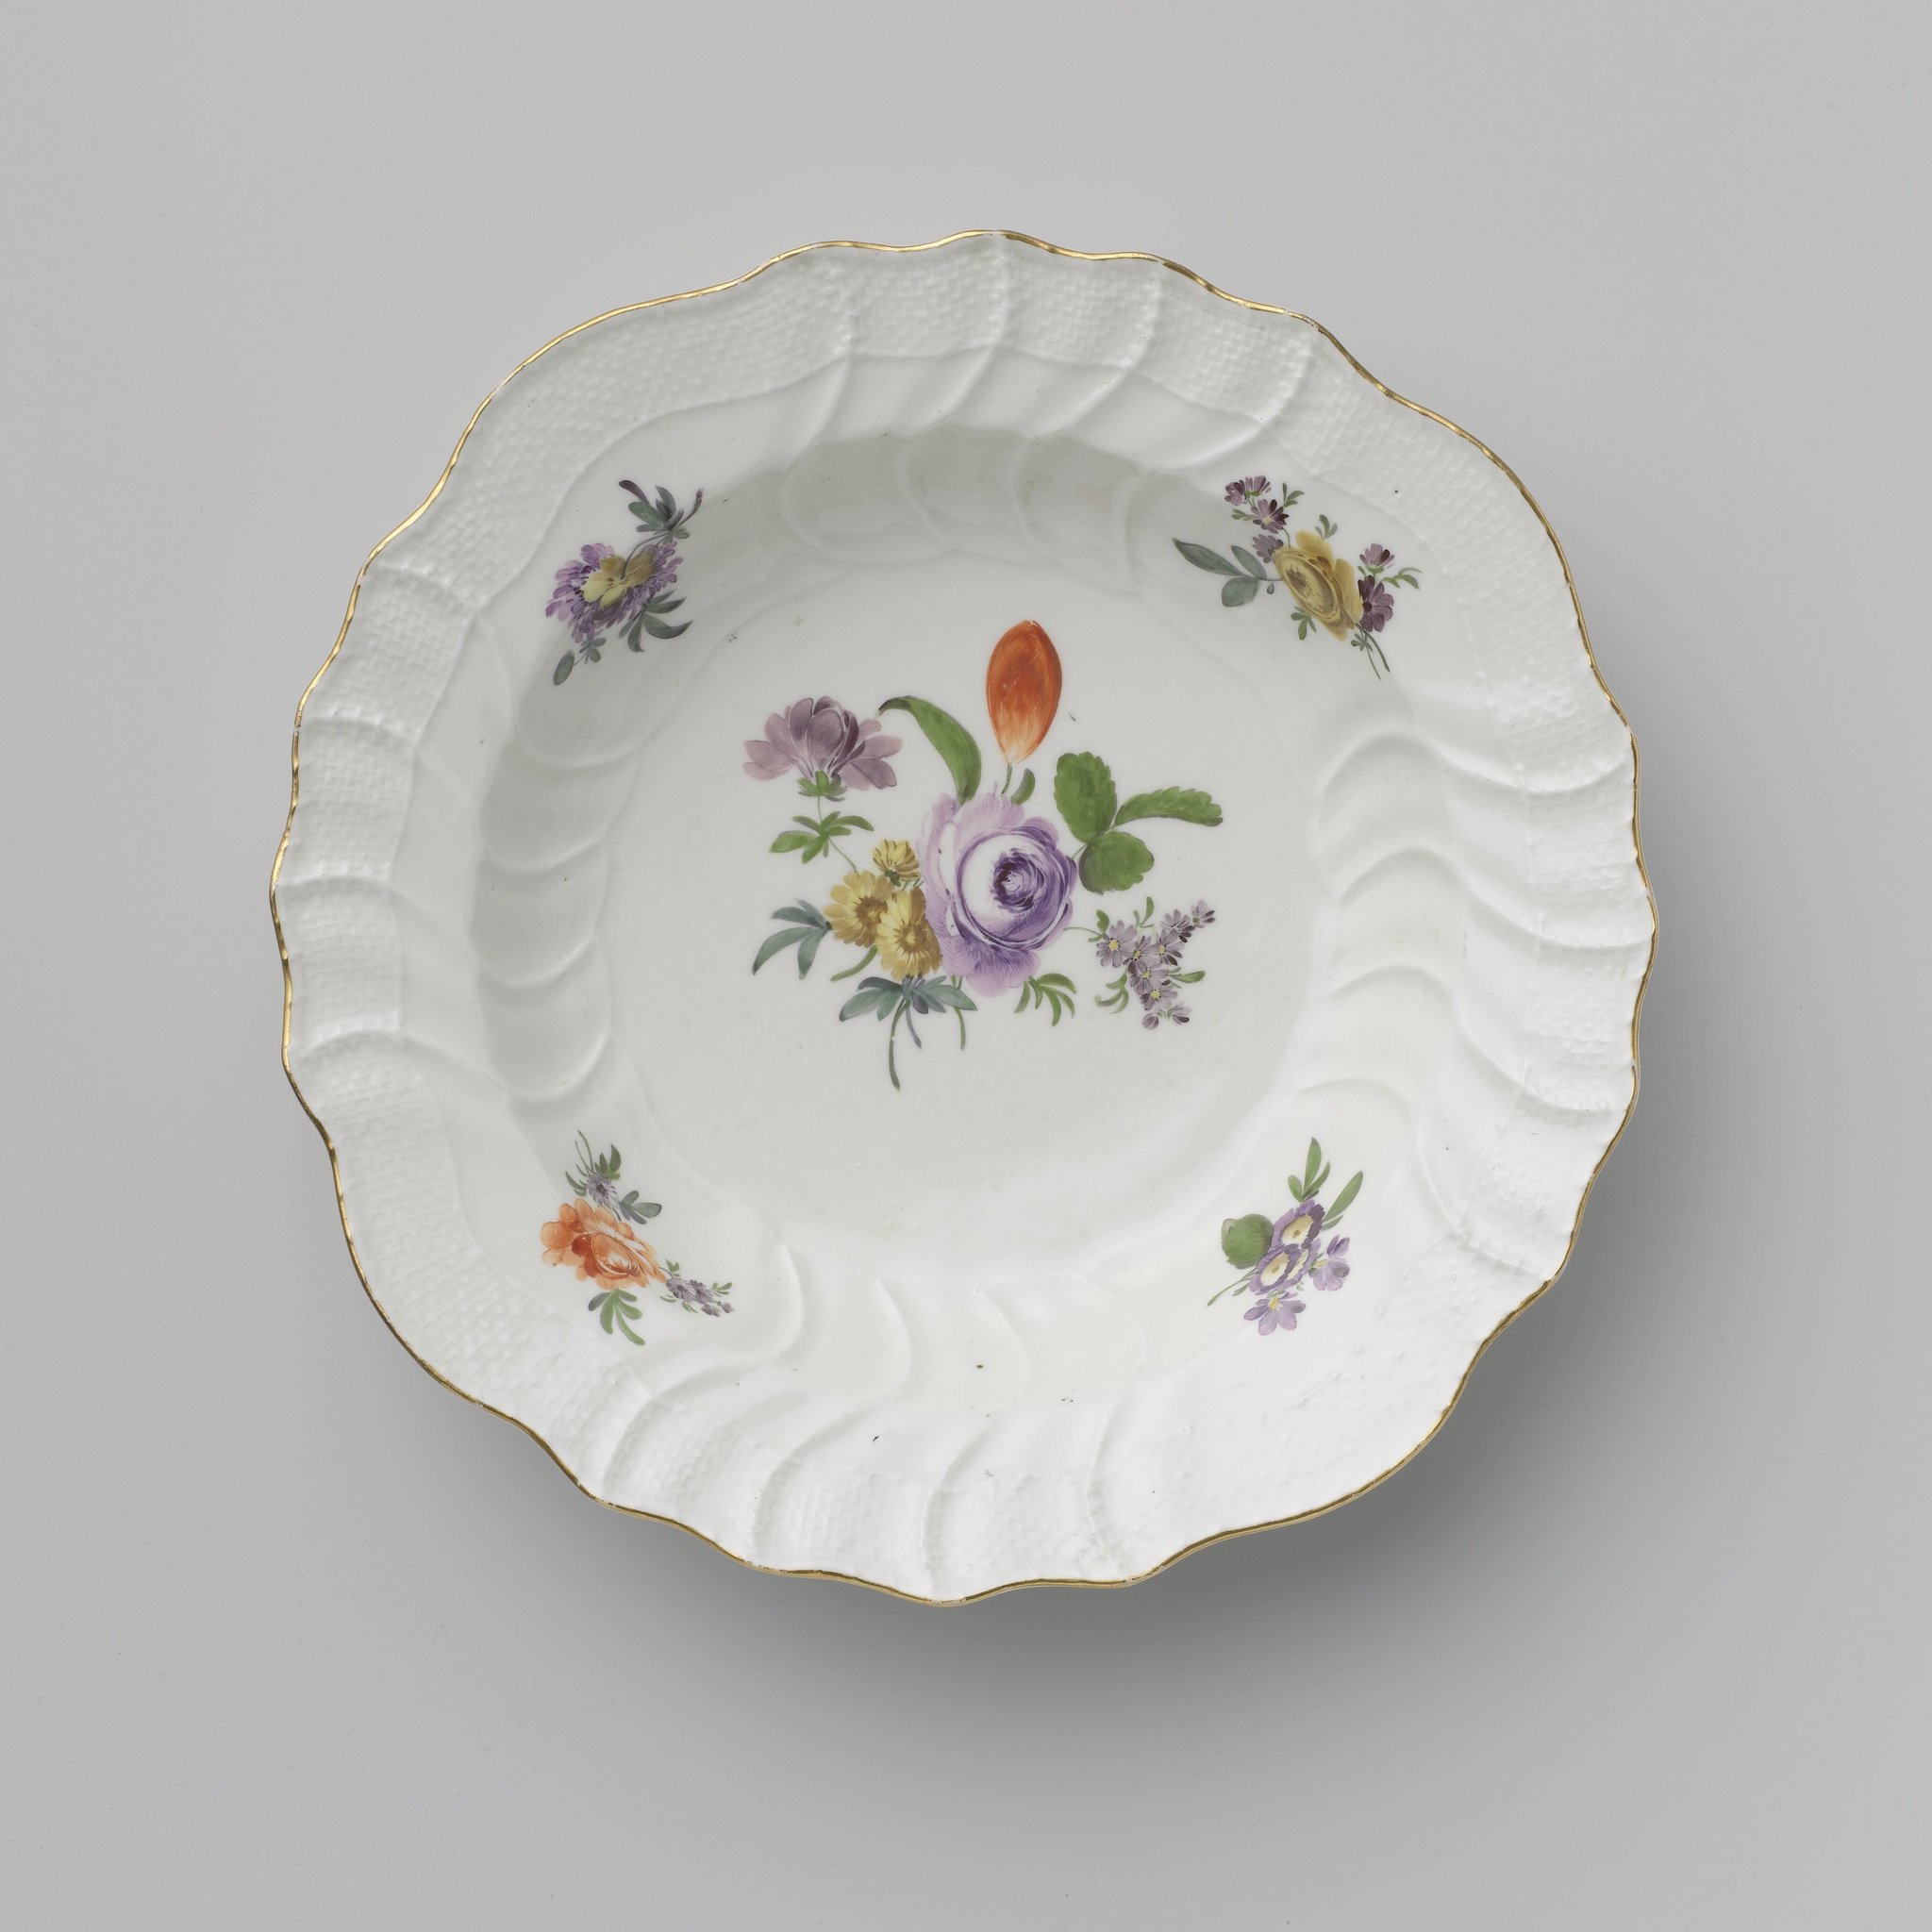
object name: plate dish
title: Bord, veelkleurig beschilderd met Deutsche Blumen, insekten en vruchten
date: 1750-1760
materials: porcelain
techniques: painted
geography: meissen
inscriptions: factory mark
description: Rond soepbord van beschilderd porselein. Het bord is beschilderd met Deutsche Blumen, insekten en vruchten. De rand is in reliëf versierd met het Neuozier-patroon. Het bord is gemerkt en hoort bij een servies (BK-17474-1 t/m BK-17474-253).